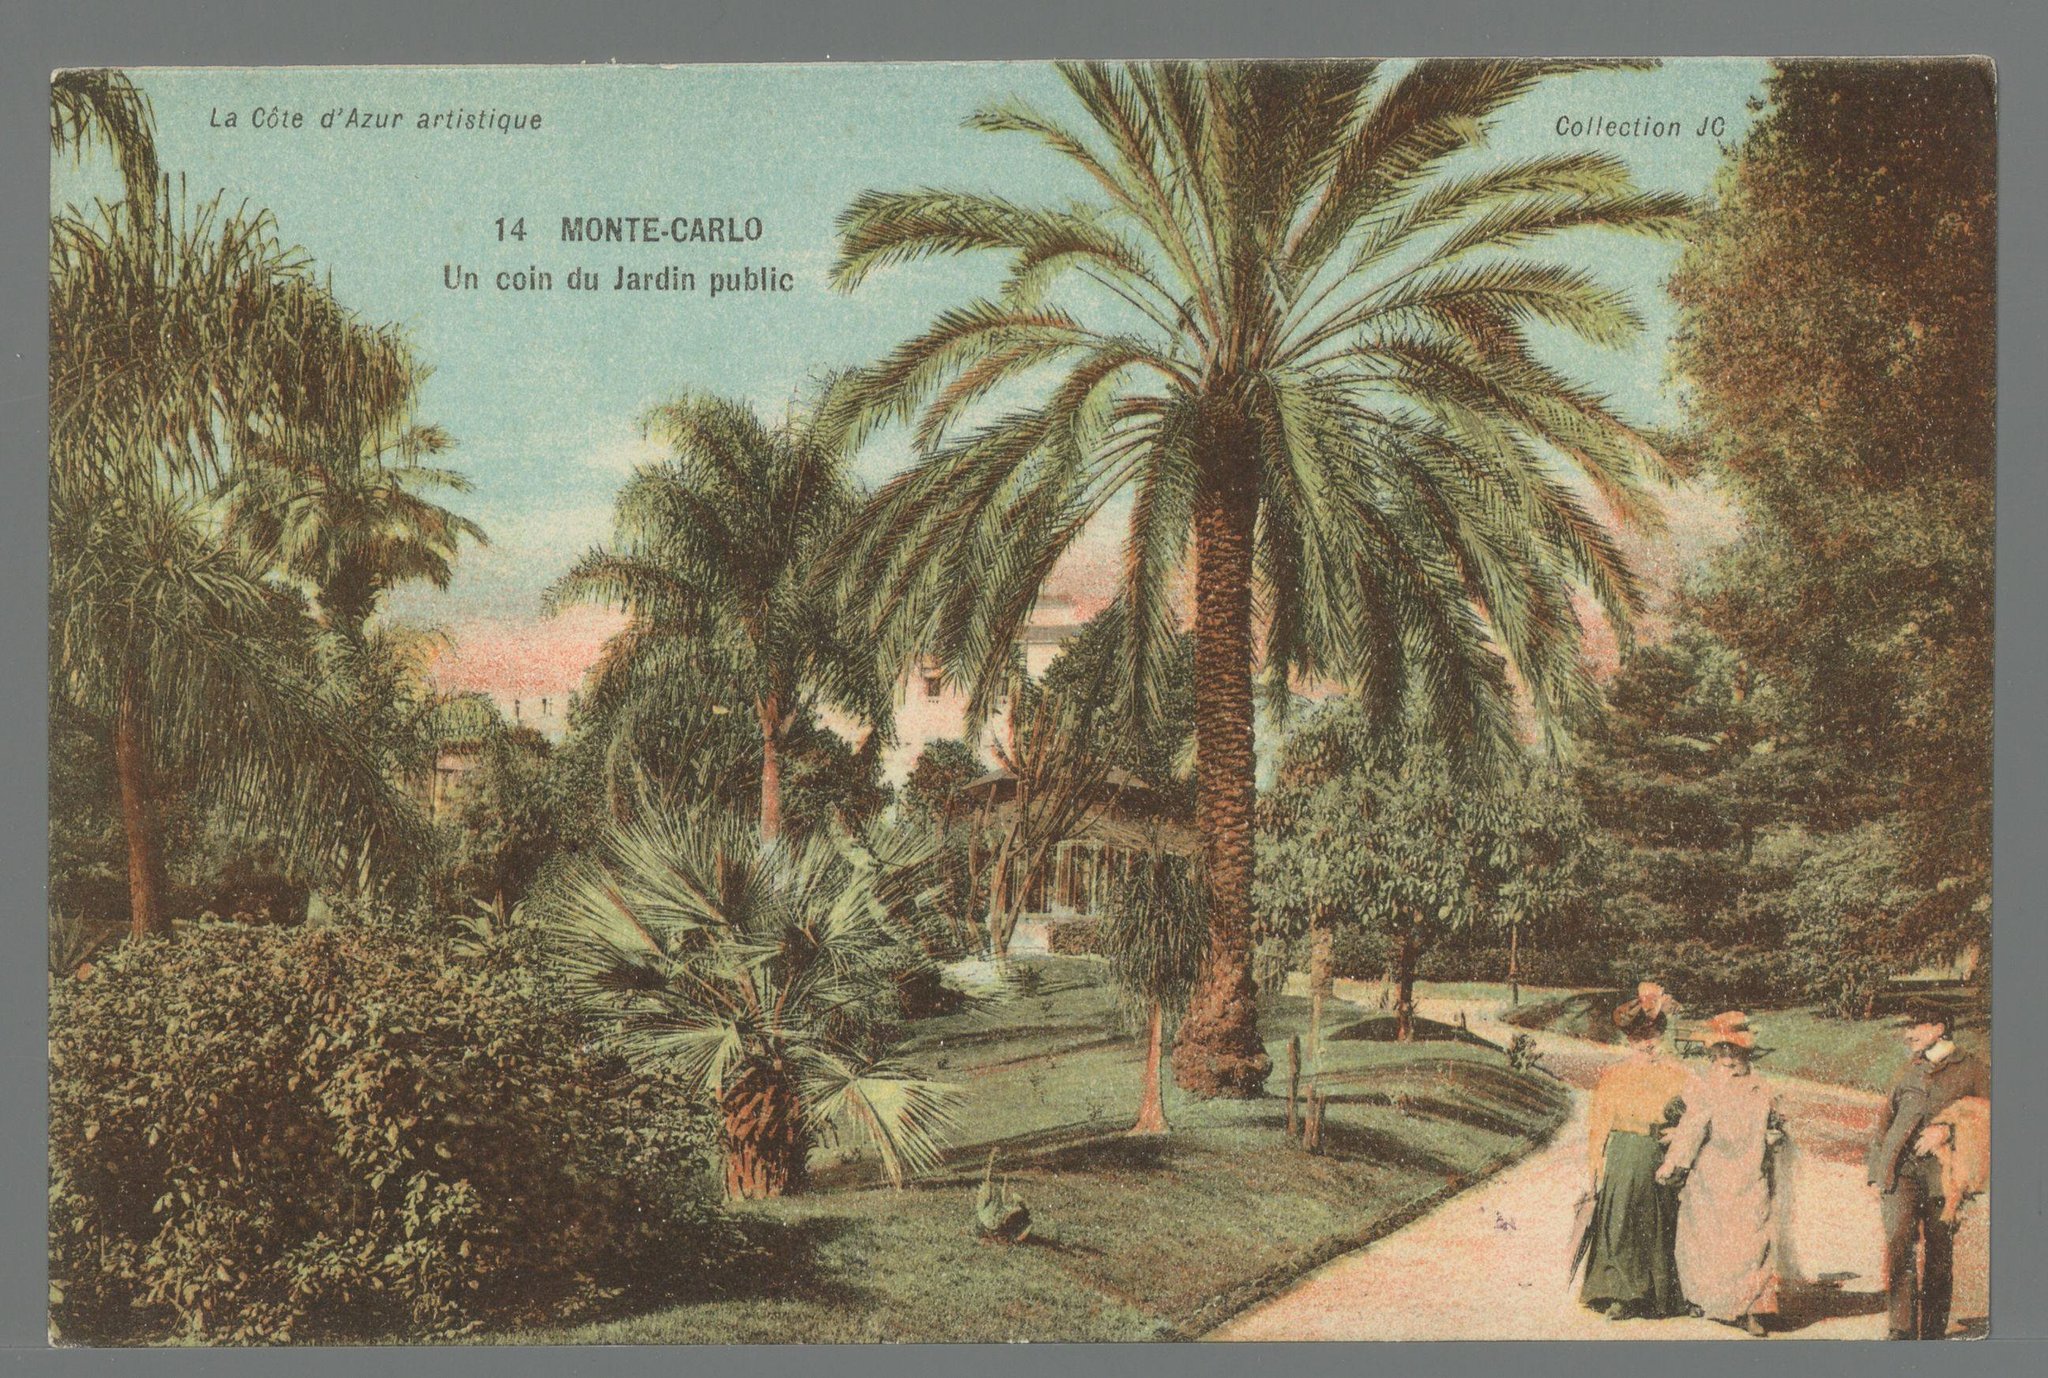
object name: photomechanical print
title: La Côte d'Azur artistique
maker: Anonymous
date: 1904-1906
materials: cardboard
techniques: photograph, lithograph, writing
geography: monte carlo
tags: public gardens, park